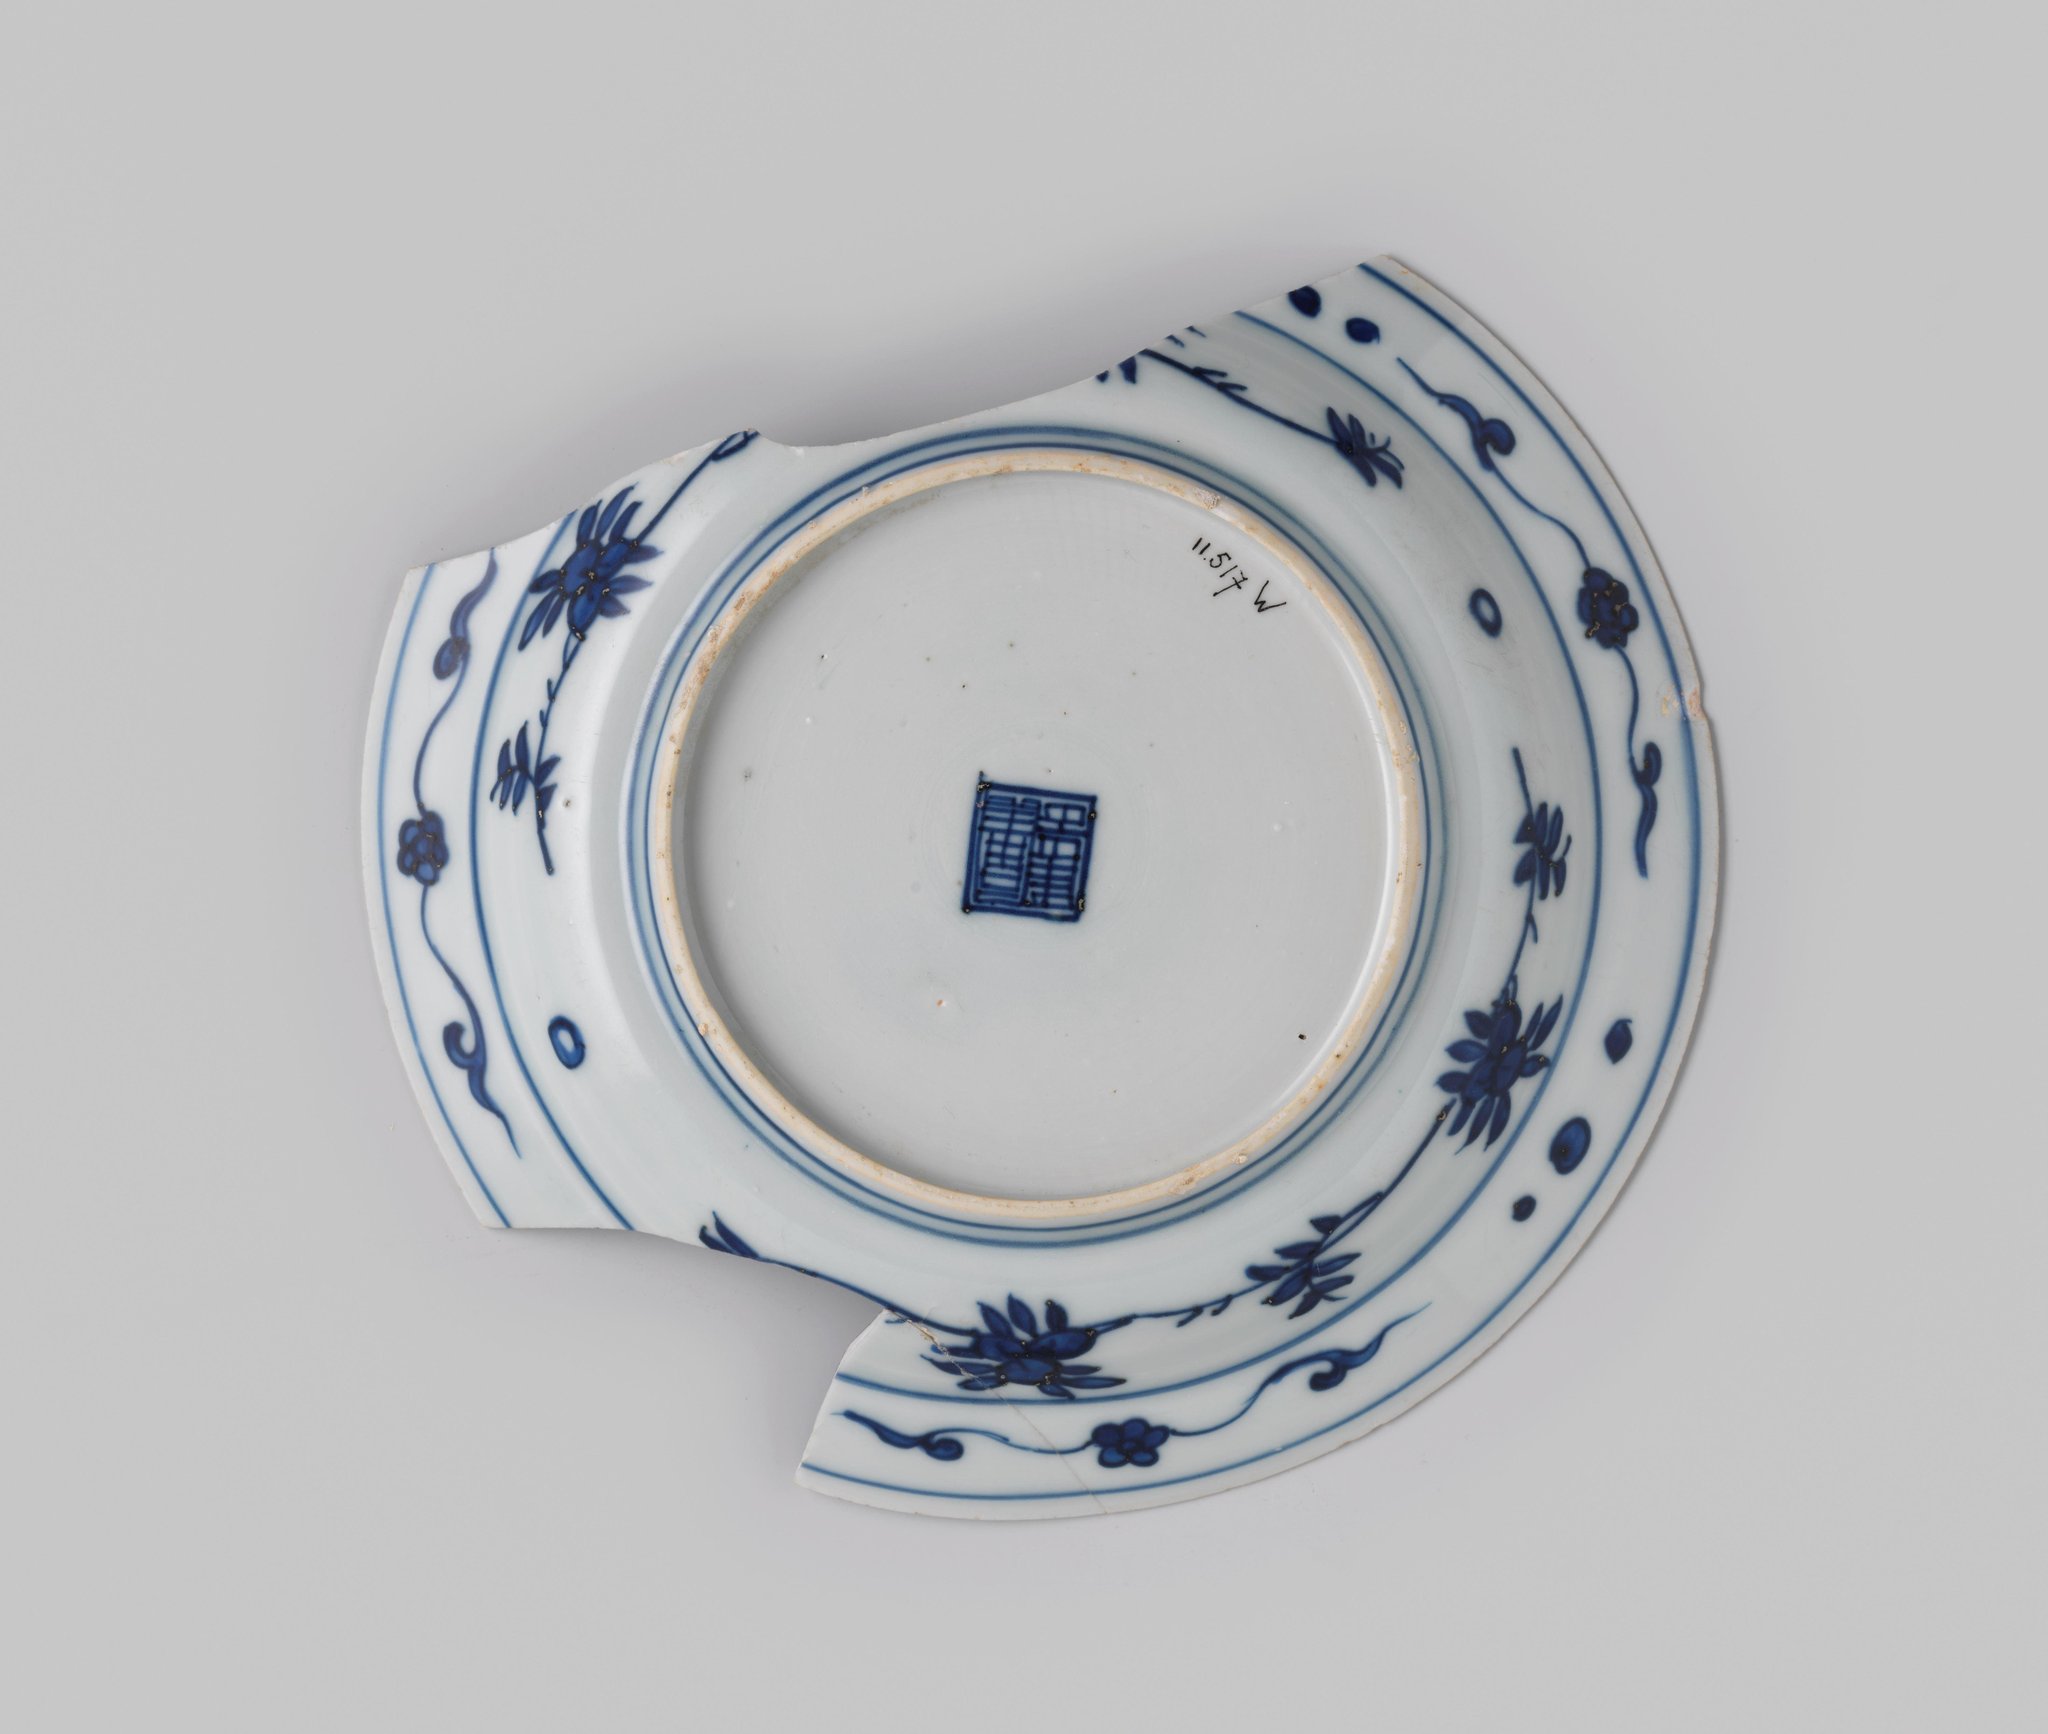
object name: plate dish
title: Fragmented dish of Chinese porcelain from the wreck of the Dutch East Indiaman Witte Leeuw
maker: Anonymous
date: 1613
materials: porcelain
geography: jingdezhen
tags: verenigde oostindische compagnie, sint-helena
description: A plate with a flattened rim. In the centre a phoenix standing on a rock with at its side a small bird, a flower and above some clouds. Around this design is a thin band of scrolls. The cavetto is blank. On the lip-rim a band which is drawn alternatingly a flower, castanets lozenge and a scroll, also there are four stems with a small flower with a group of dots in between. On the outside twice a long stem with three tiny peaches with in between a small circle.